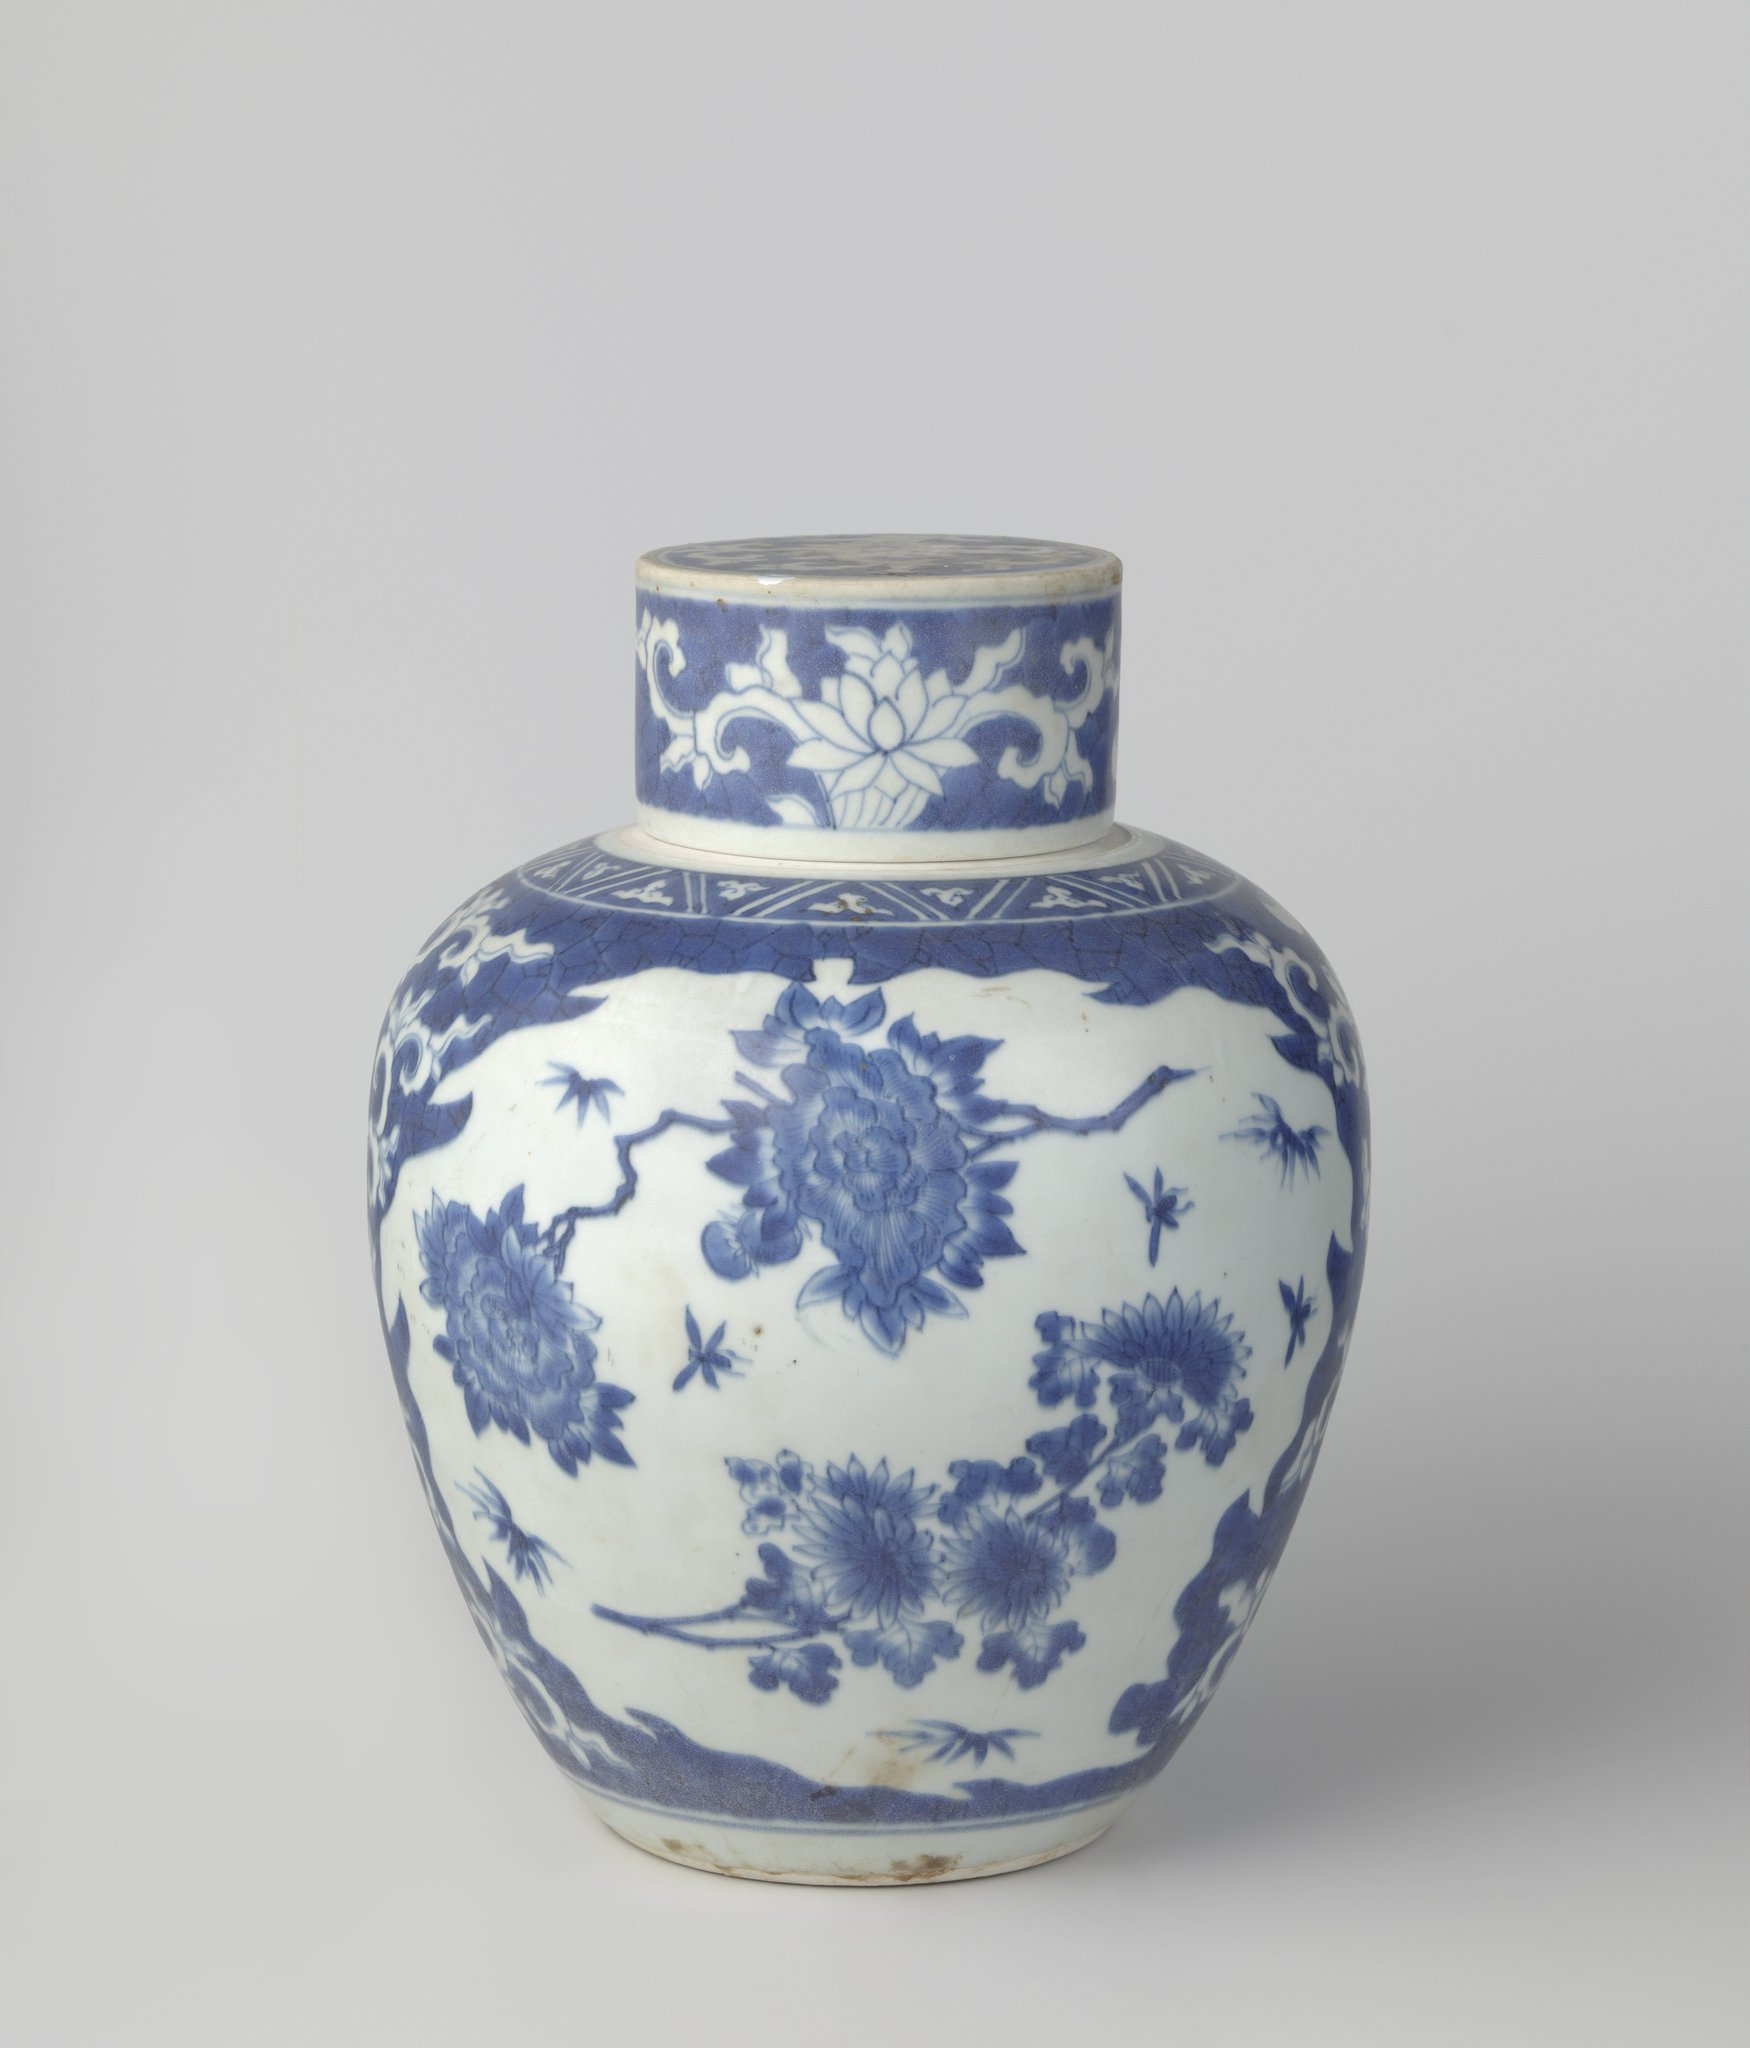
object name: covered jar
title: Ovoid covered jar with flower sprays and floral scrolls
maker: Anonymous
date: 1645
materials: cobalt, glaze, paint, porcelain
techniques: firing, turning, vitrification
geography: china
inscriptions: label: ‘The Hatcher Collection/ Christie's Amsterdam/ 14-03-1984’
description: Eivormige dekselpot van porselein met een cilindrische dop, beschilderd in onderglazuur blauw. De buik is bedekt met 'crackled ice' met daarin uitgespaard lotusranken, parels en twee grote, bladvormige cartouches. In de cartouches telkens twee bloemtakken (pioen, chrysant, magnolia, hortensia) en bamboebladeren of insecten. Op de schouder een band met driehoeken in blauw met daarin uitgespaard een motief. De deksel met dezelfde decoratie. Afkomstig uit de 'Hatcher jonk' die ongeveer 1645 verging. Oud label op de onderzijde met 'The Hatcher Collection/ Christie's Amsterdam/ 14-03-1984'. Een chip in de deksel. Overgangsporselein inblauw-wit.